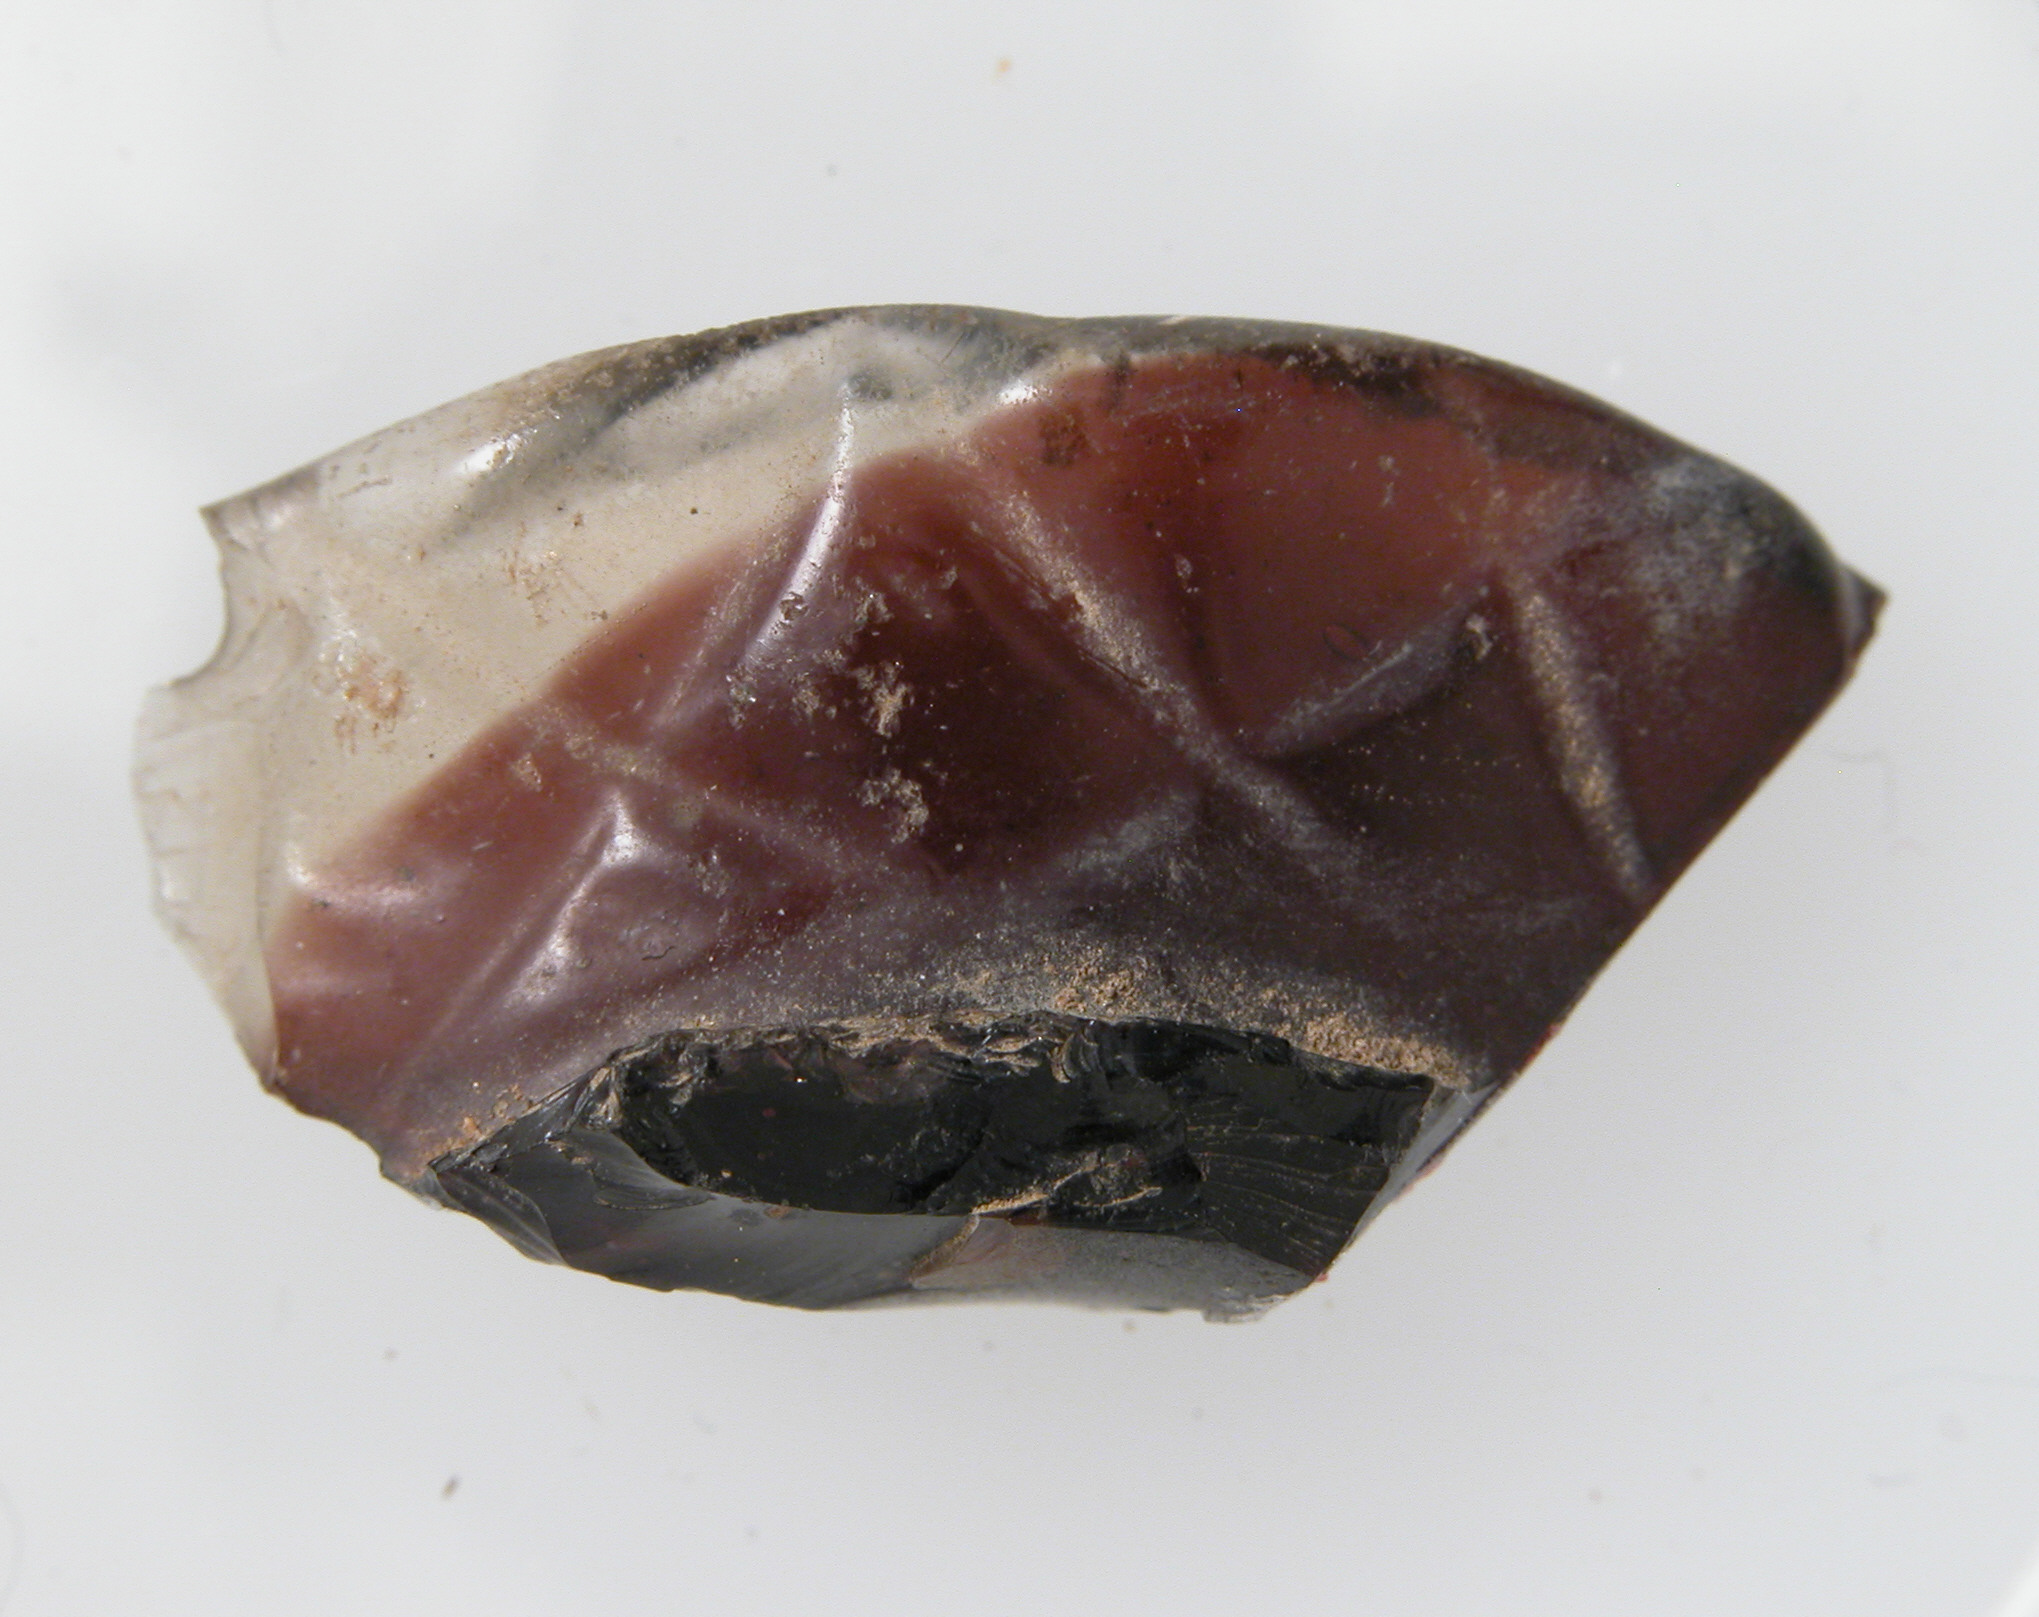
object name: fragment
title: Glass Fragment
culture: coptic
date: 301-433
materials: glass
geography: egypt